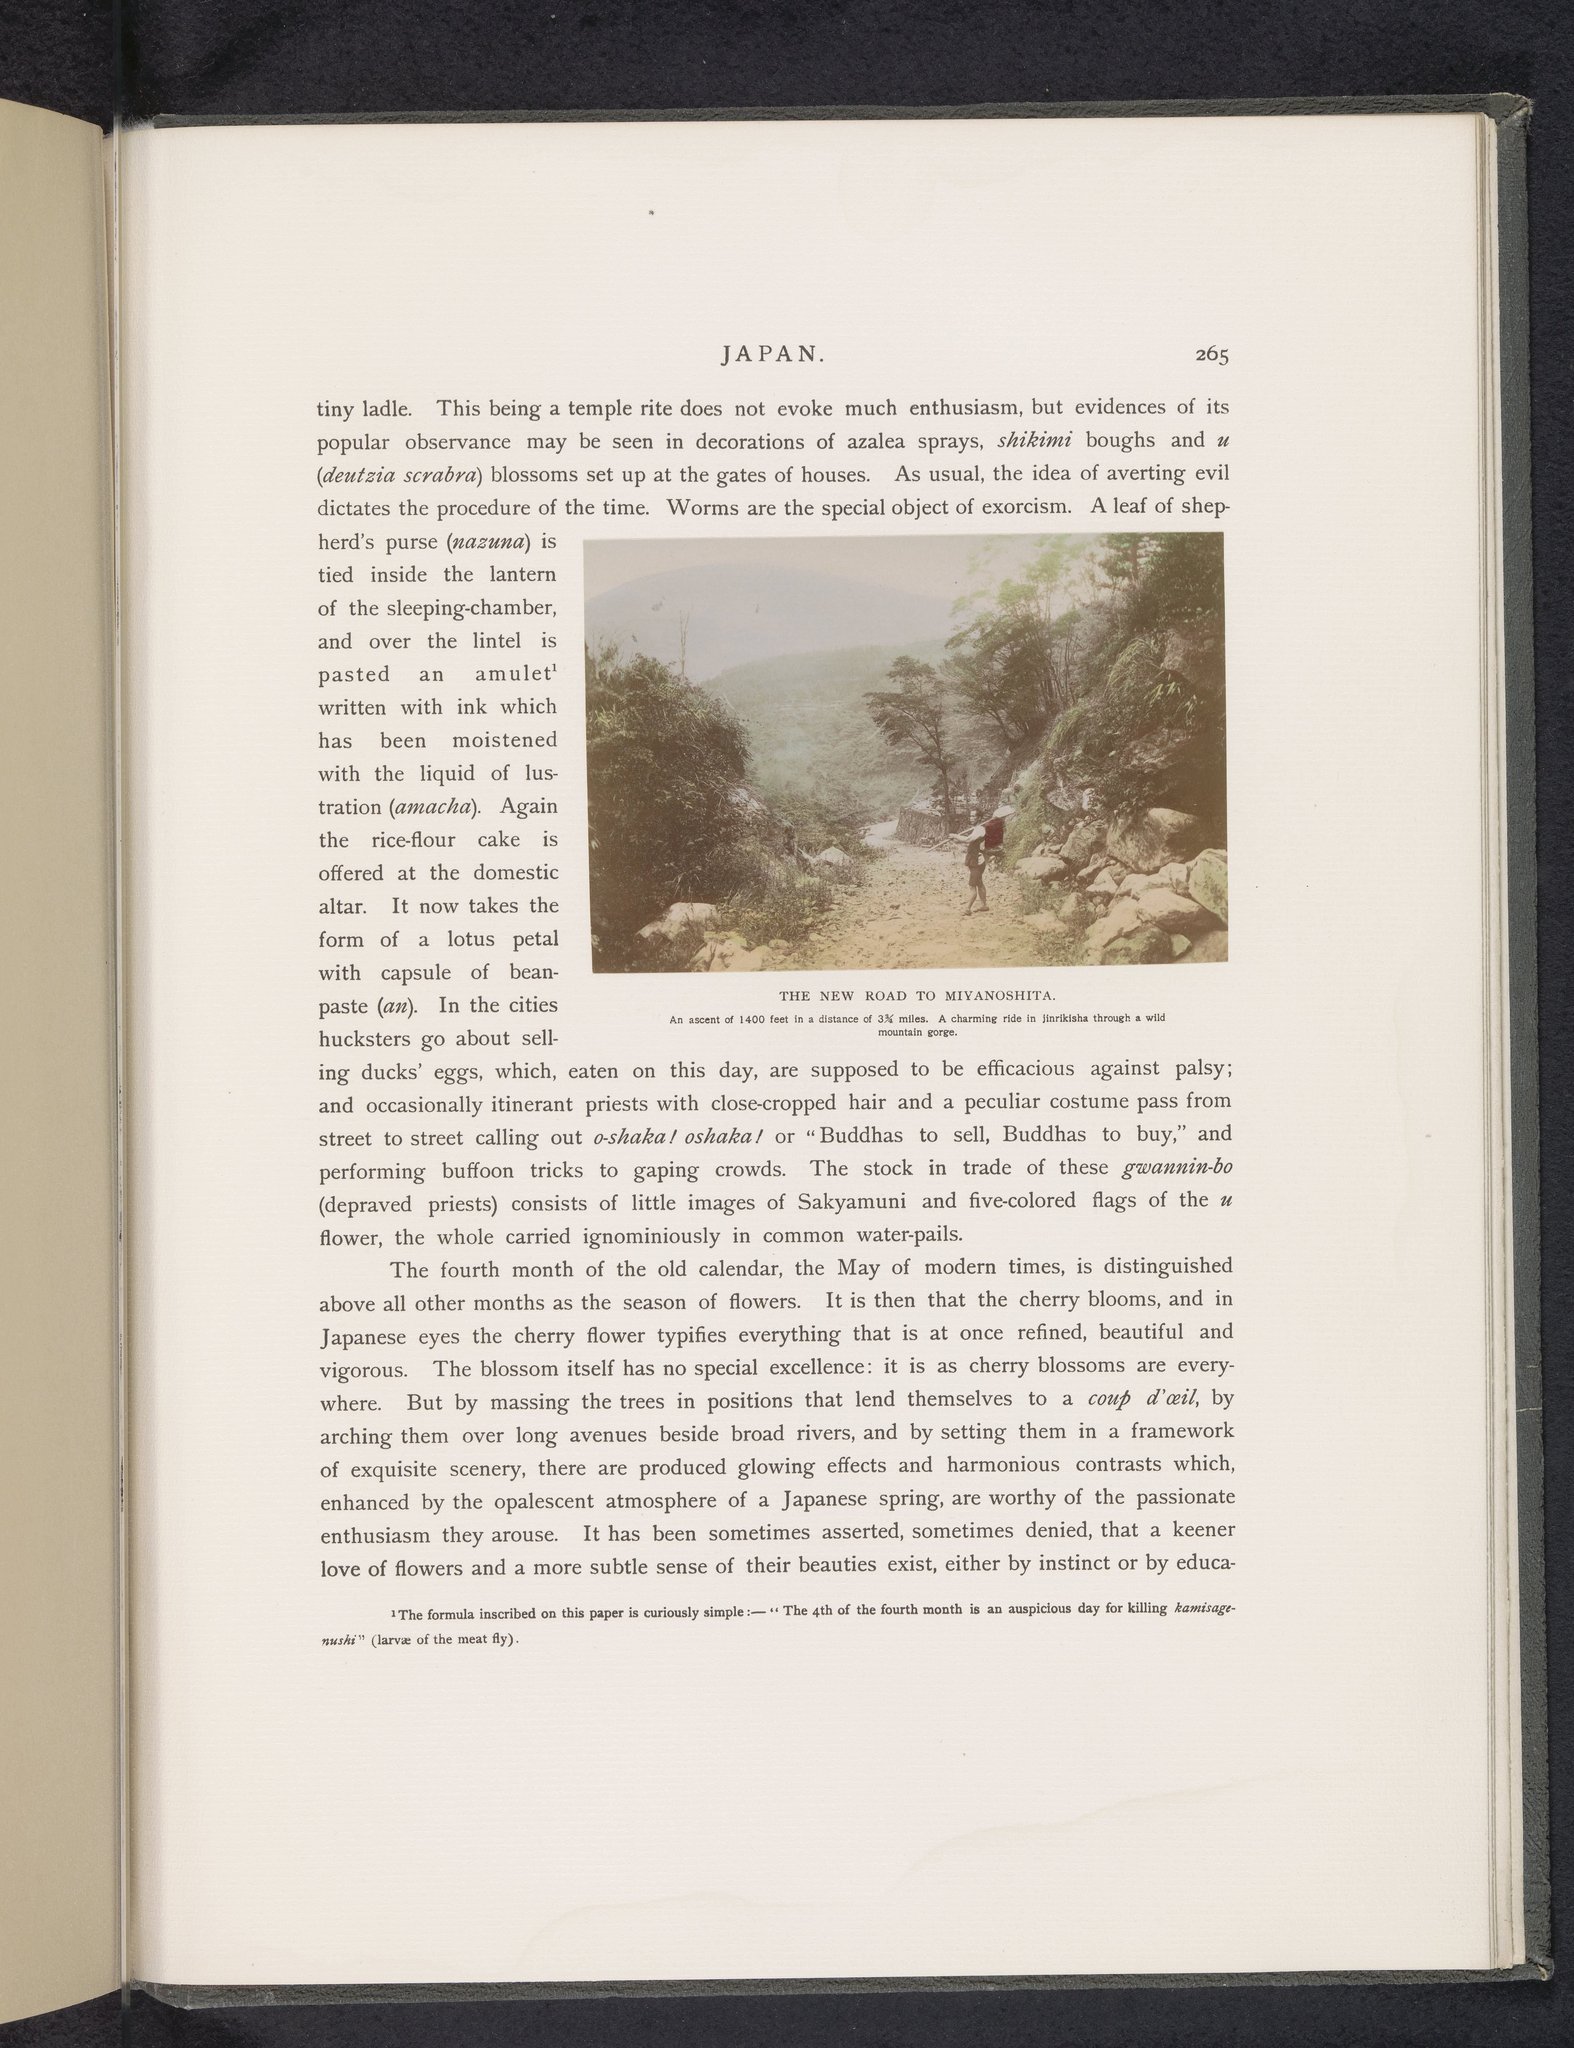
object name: page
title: The new road to Miyanoshita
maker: Anonymous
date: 1887-1897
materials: photographic support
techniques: albumen print, hand coloring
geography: japan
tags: low hill country, public road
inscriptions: inscription: ‘An ascent of 1400 feet to a distance of 3 3/4 miles. A charming ride in jinrikisha through a wild mountain gorge.’